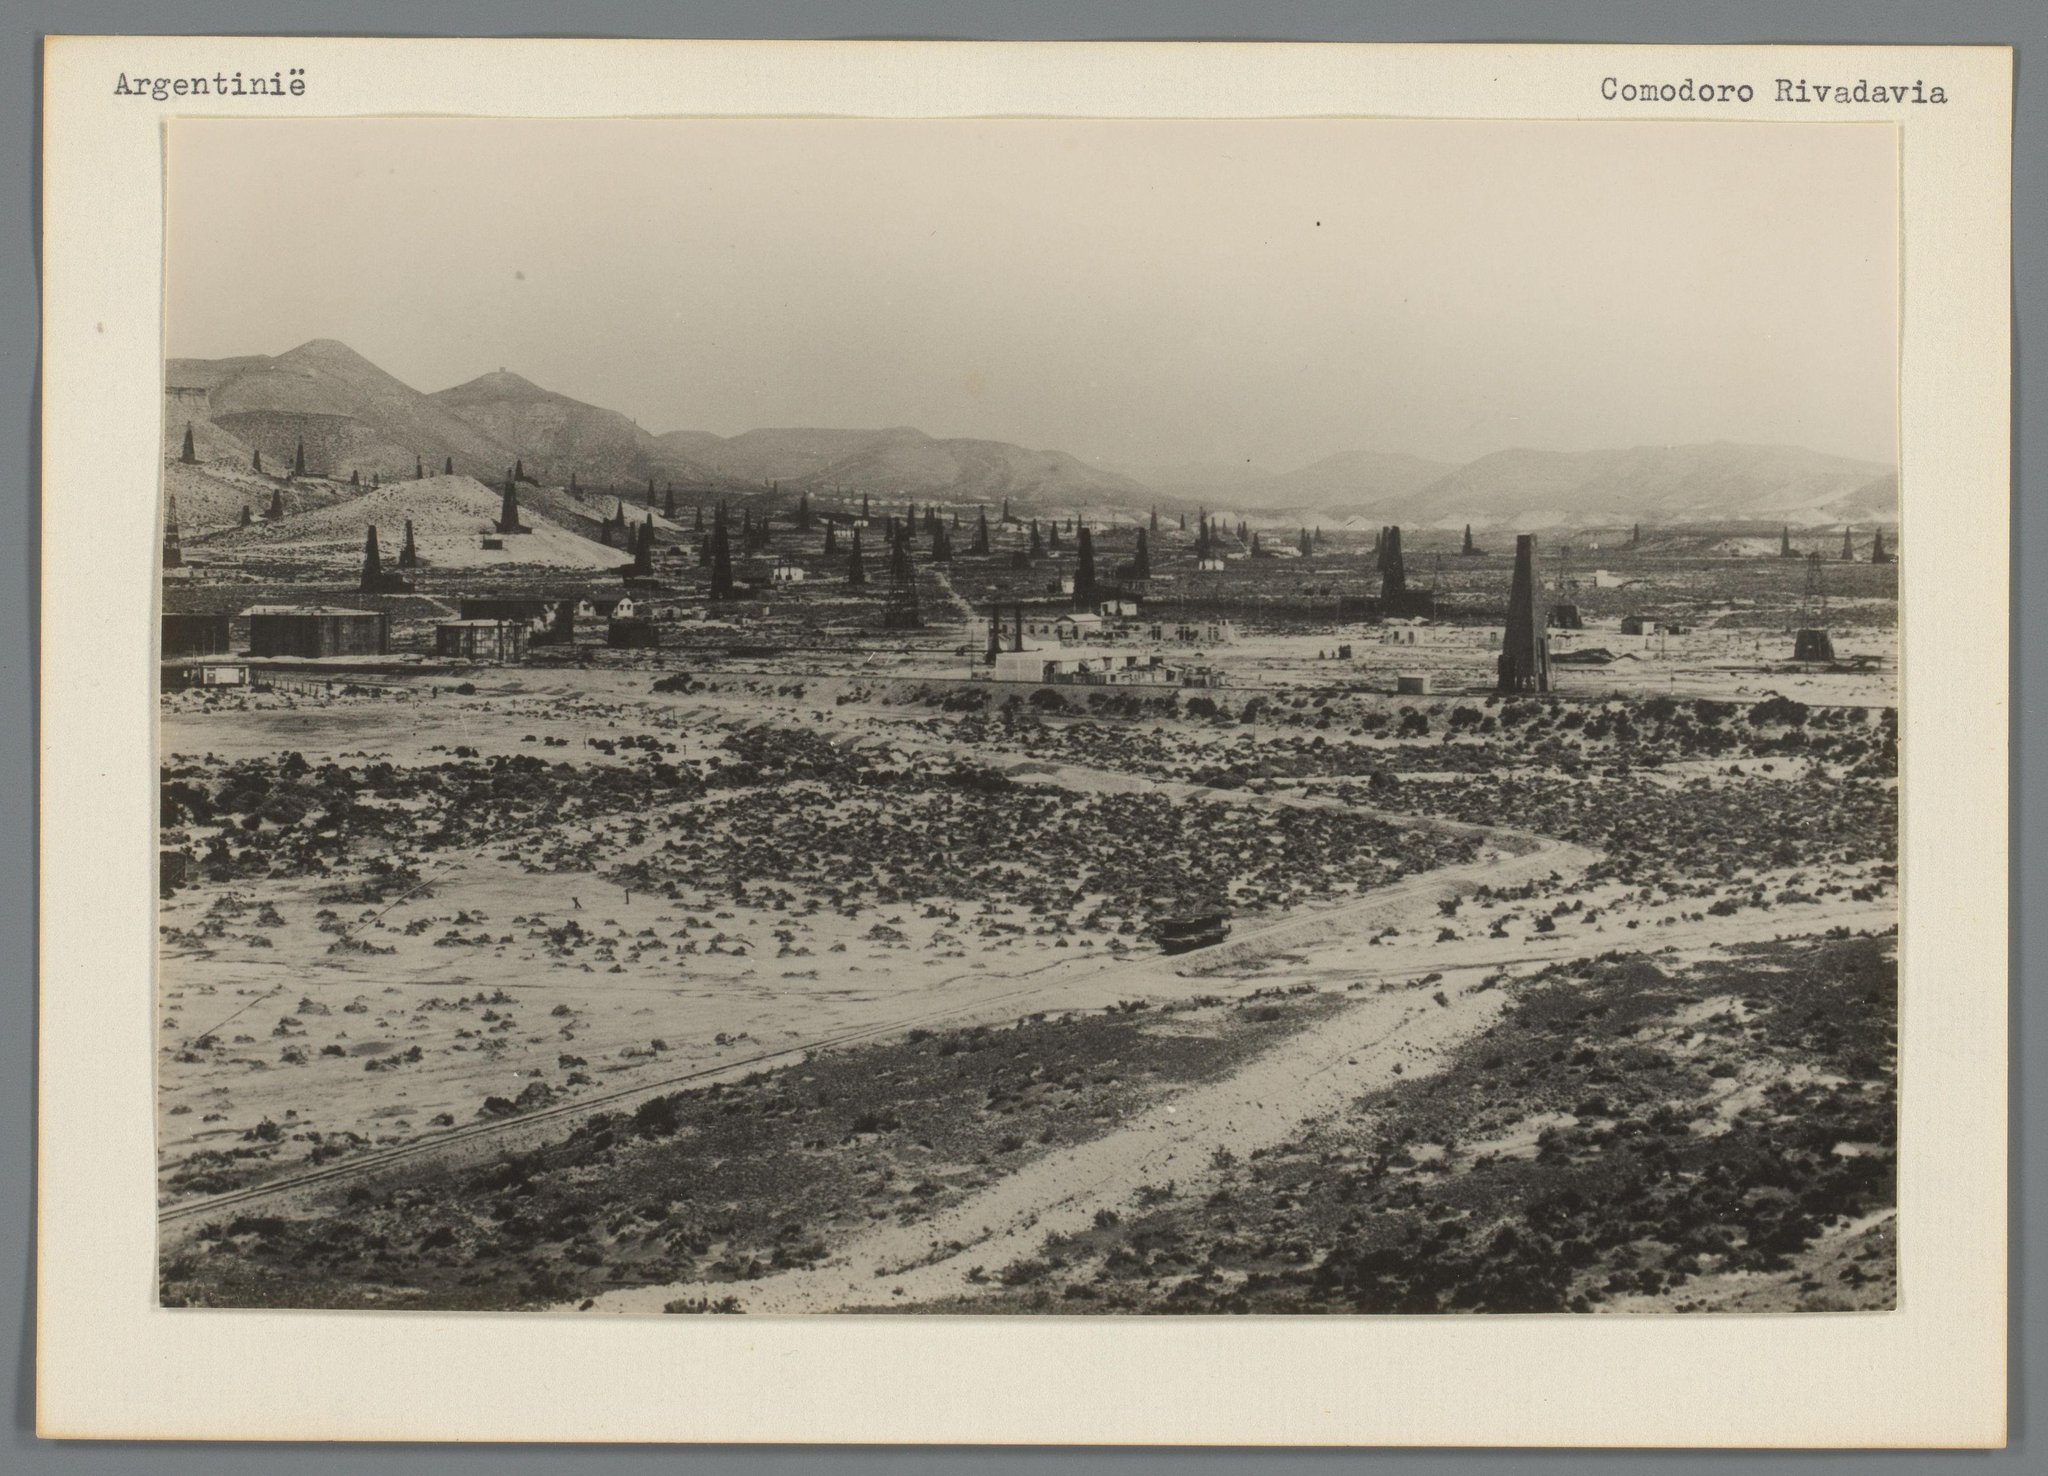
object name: photograph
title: Argentinië. Comodoro Rivadavia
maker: Anonymous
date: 1900-1930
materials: paper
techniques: gelatin silver print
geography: comodoro rivadavia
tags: pumping of oil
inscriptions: stamp: ‘REPÚBLICA ARGENTINA/ MINISTERIO D'AGRICULTURA DE LA MACIOR/ [...]/ DIVISION FOTO-CINEMATOGRAFIA’, number: ‘970000’, inscription: ‘(1)/ - Valle "C". Yacimientos Petroliferos Fiscales de Comodoro Rivadavia./ Vallée "C". Gisemente Pétrolifères Fiscaux à Comodoro Rivadavia (Rép. Argentina)’, number: ‘40.913’, inscription: ‘Boortorens’